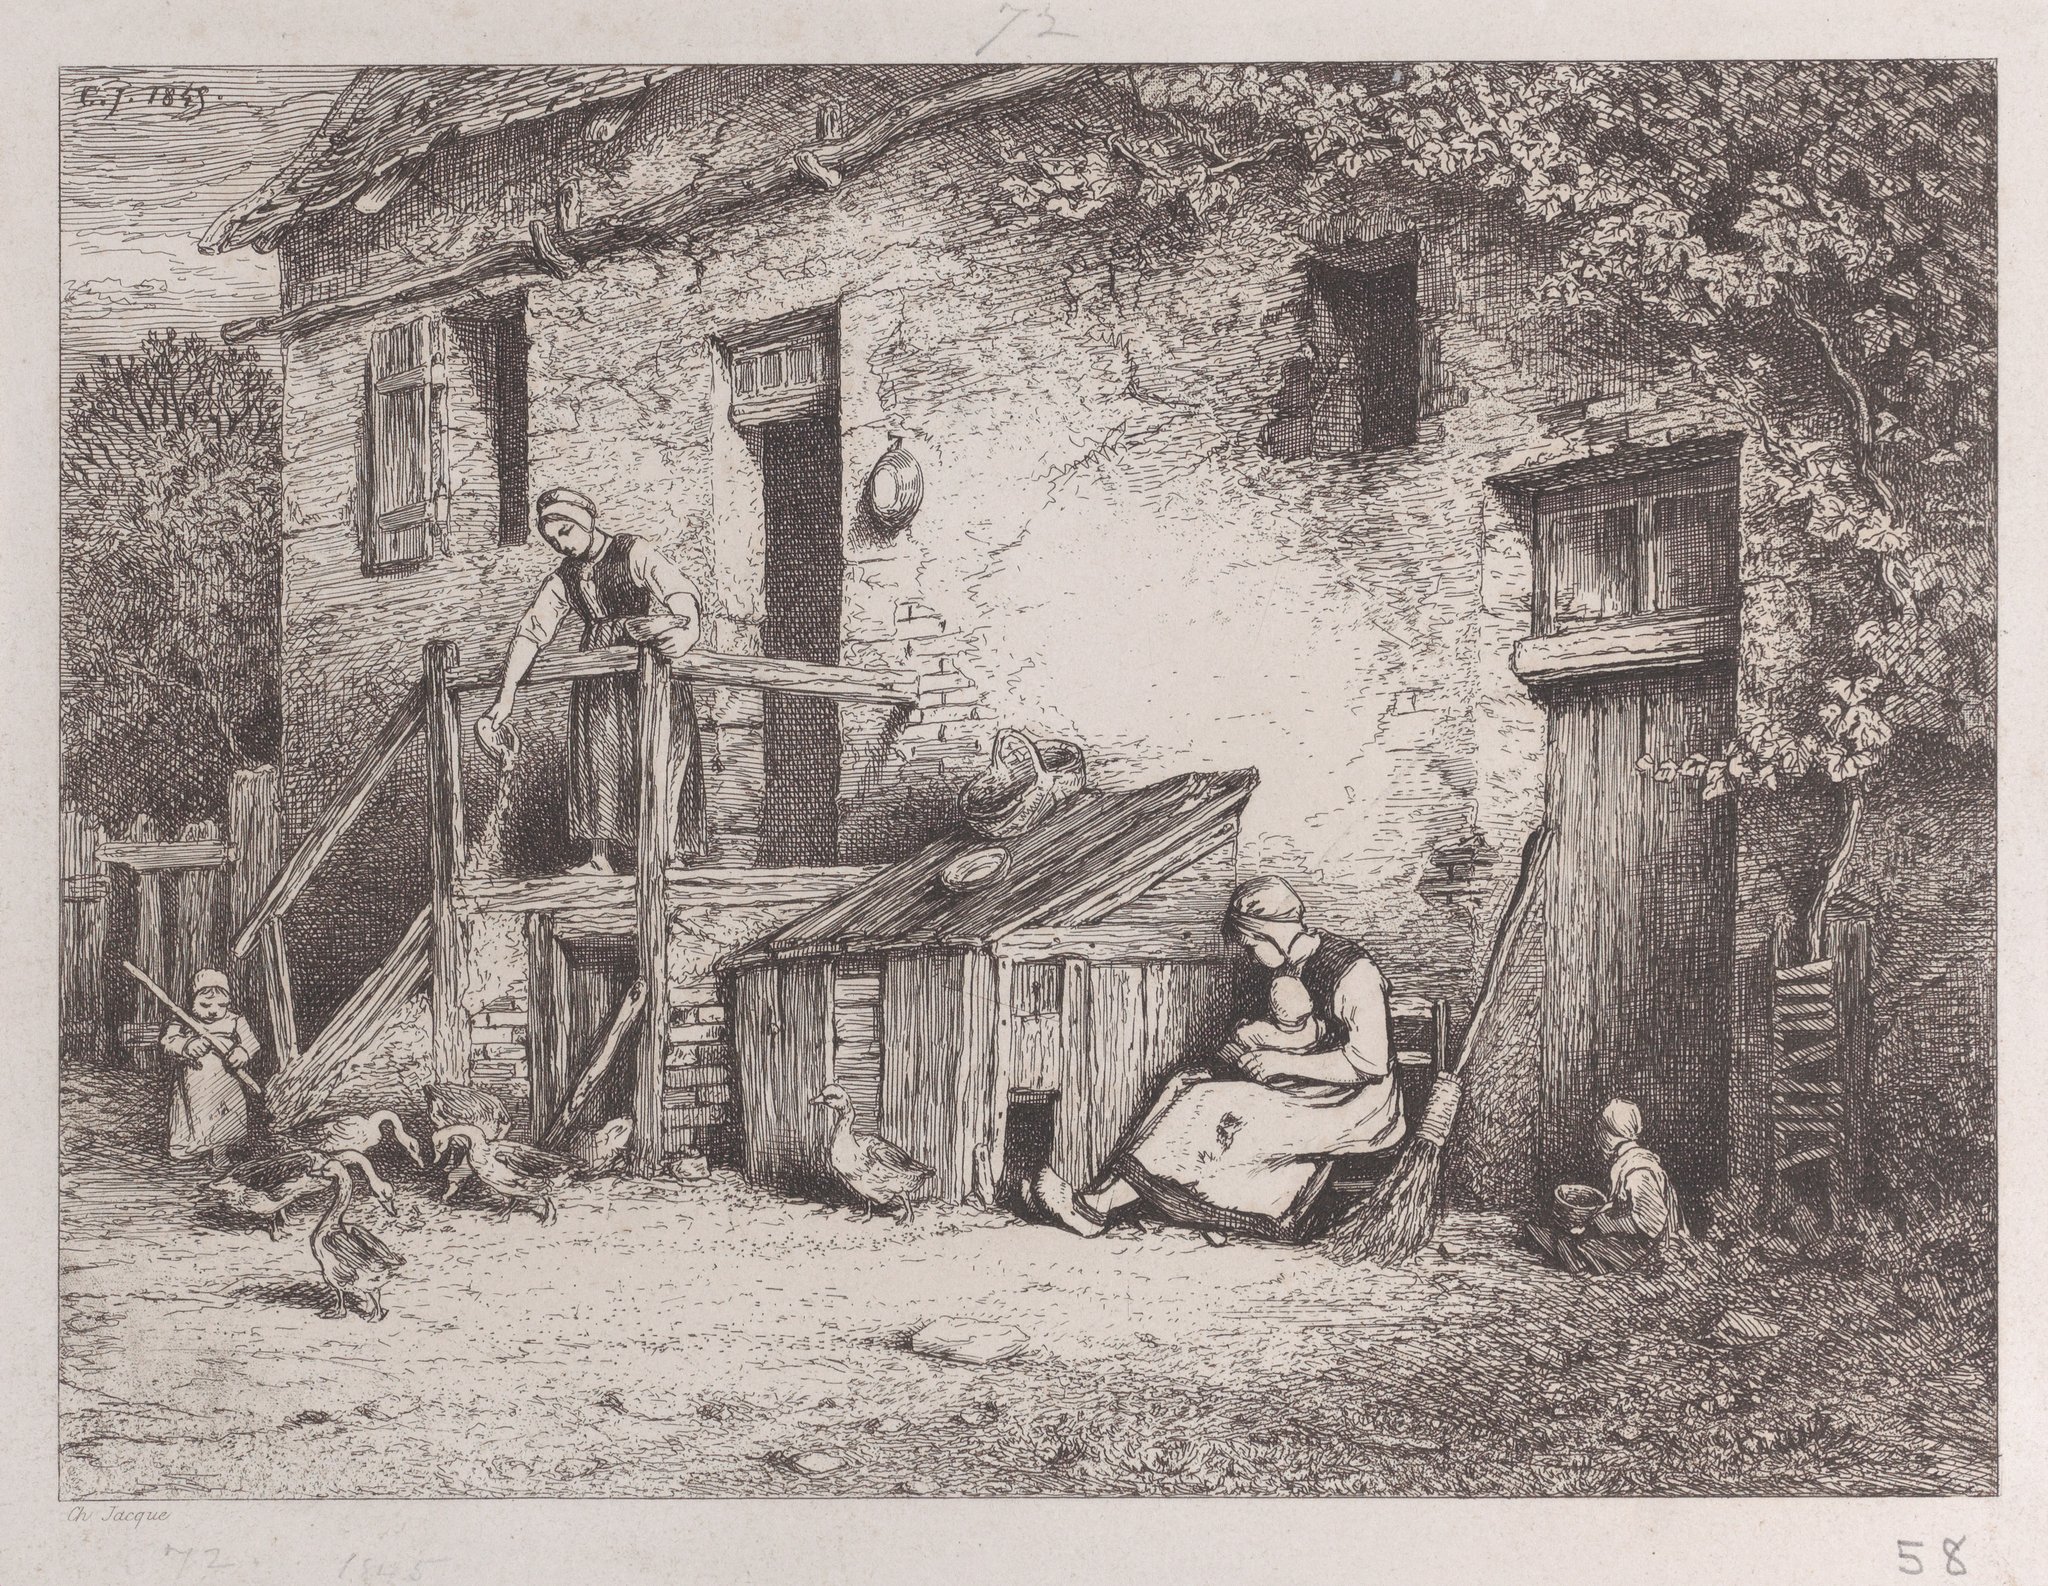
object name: print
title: In Front of the House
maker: charles émile jacque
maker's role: artist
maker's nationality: french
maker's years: 1813-1894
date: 1845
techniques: etching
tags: ducks,houses,children,women